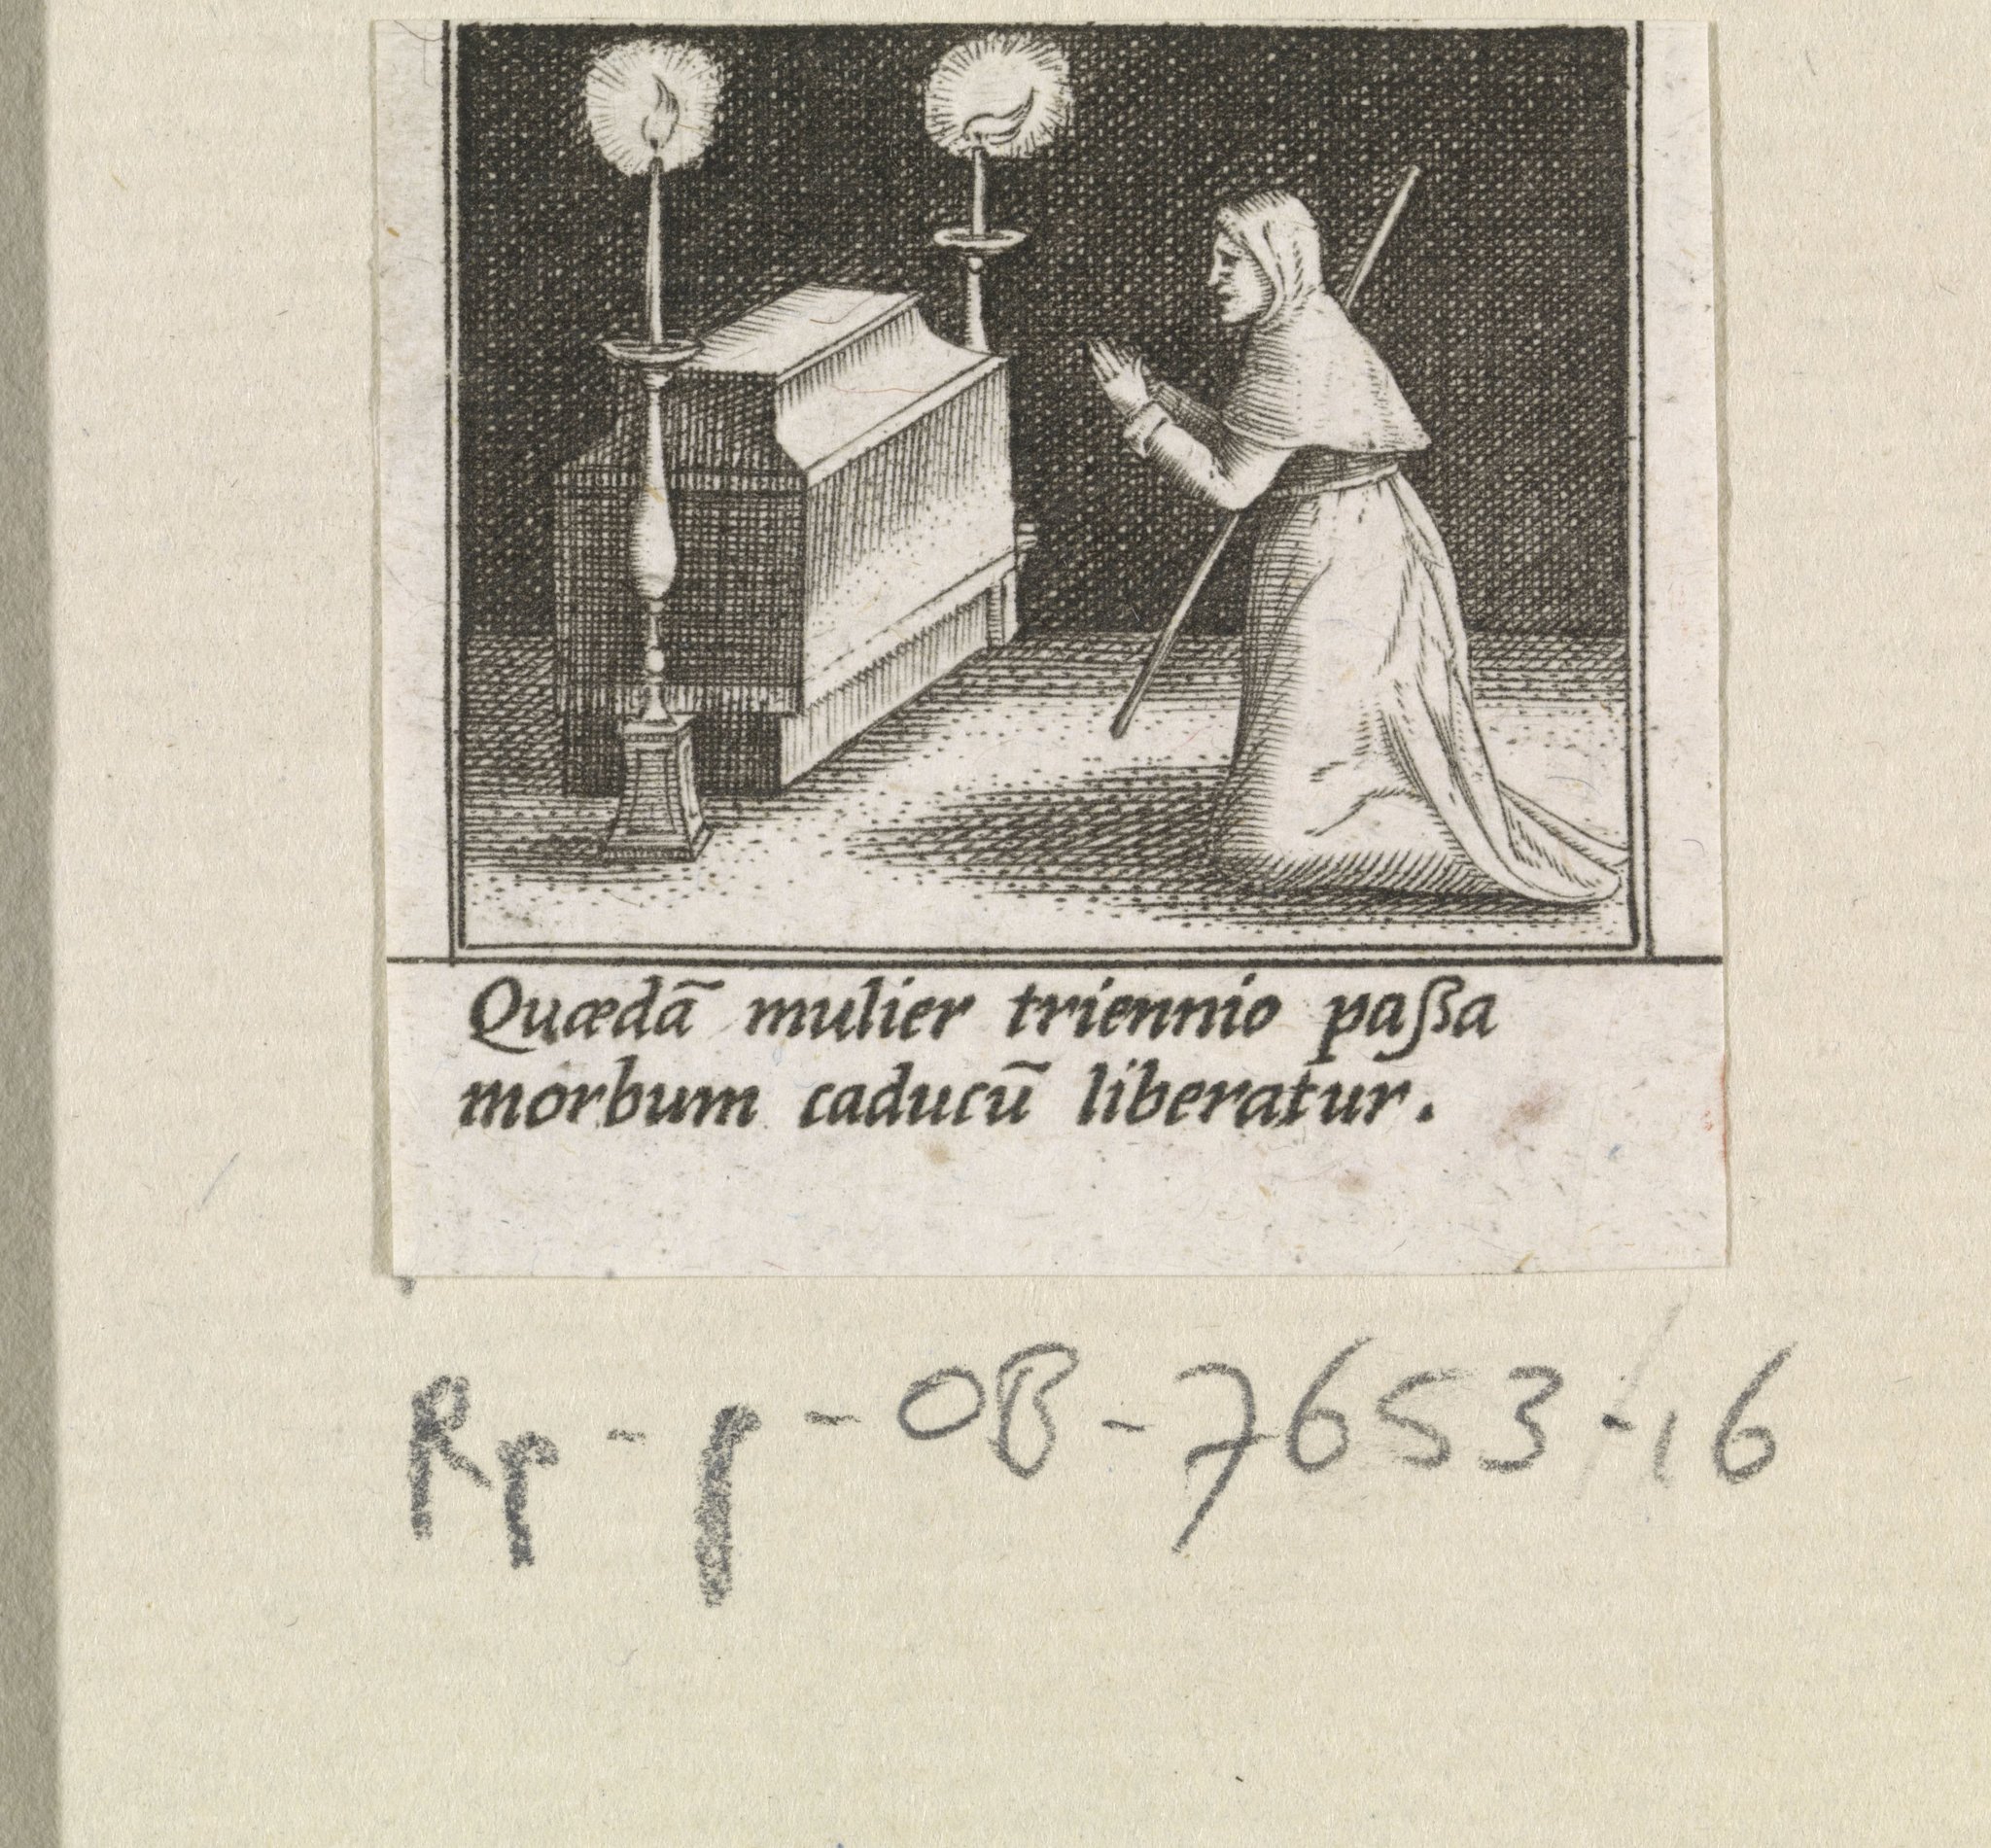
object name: print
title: Mirakels van de Heilige Hyacinthus van Polen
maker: johann sadeler (i)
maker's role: print maker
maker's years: 1550-1600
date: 1595-1600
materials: paper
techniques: engraving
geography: venice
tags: the dominican friar hyacinth(us) of poland; possible attributes: book, lily, monstrance (or ciborium), statue of the virgin - post-mortem occurrences ~ male saint, pilgrim(s), grave, tomb, one person praying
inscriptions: collector's mark: Lugt 240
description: Een tombe van de H. Hyacinthus van Polen met aan weerszijden een kaars. Een pelgrim bidt bij het graf. De prent maakt deel uit van een achttiendelige serie die een kader vormt rondom een afbeelding van de H. Hyacinthus van Polen.